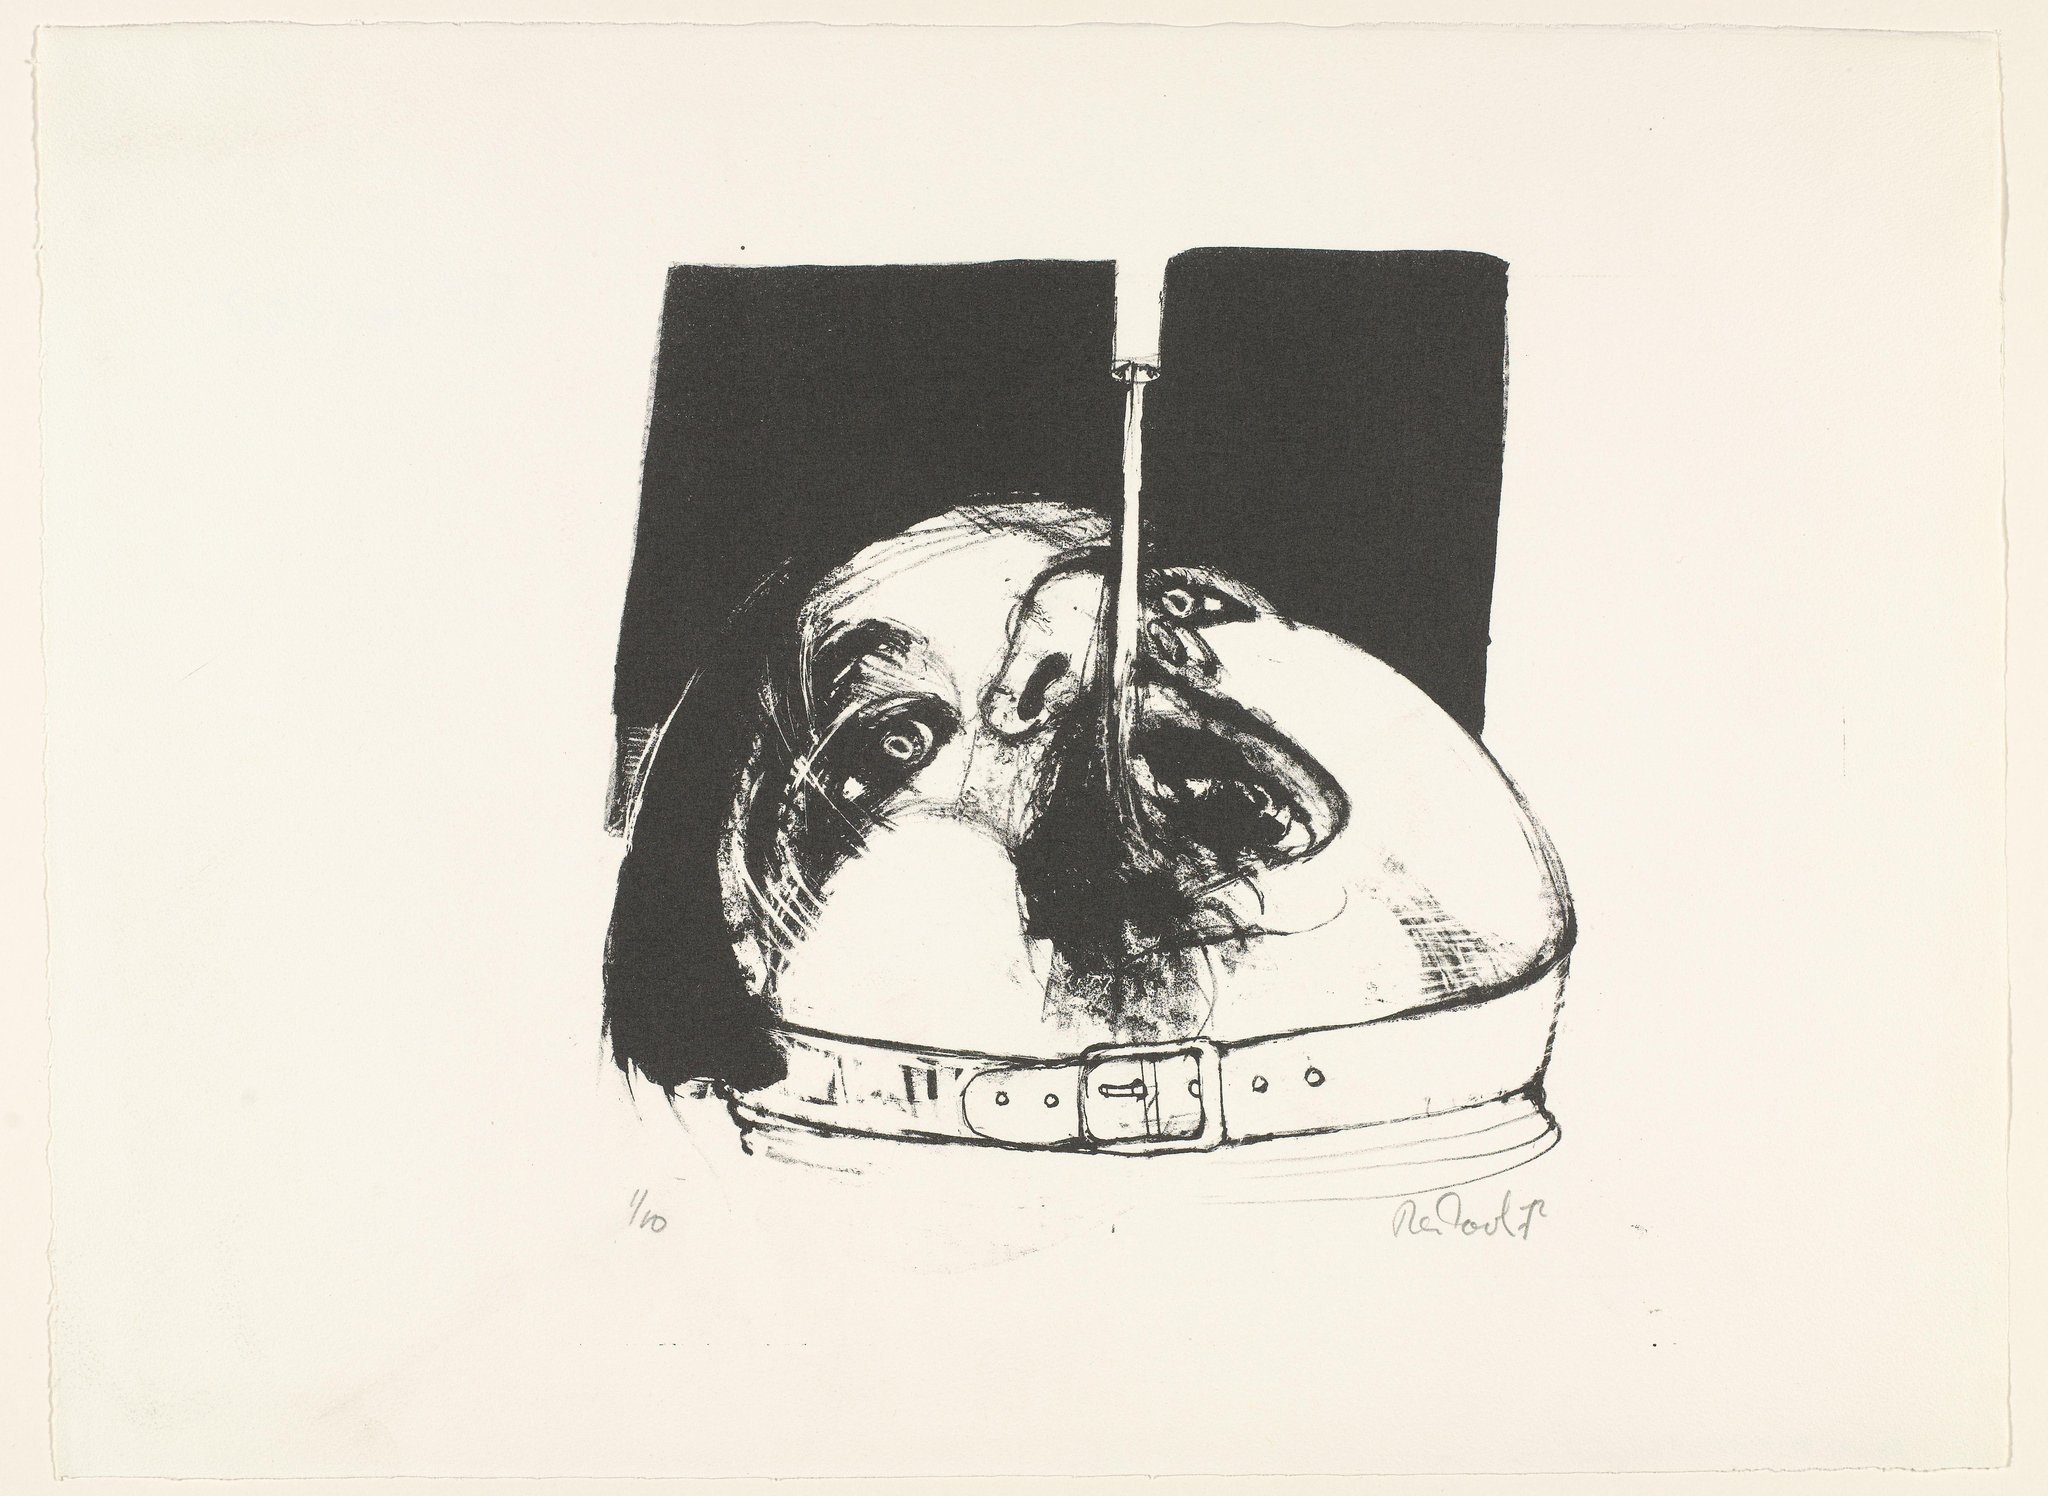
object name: print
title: Drinkende figuur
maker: rein dool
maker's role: draughtsman, painter, print maker, sculptor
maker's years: 1933-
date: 1972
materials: paper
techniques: lithograph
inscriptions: signature and date: ‘Rein Dool 72’, edition: ‘1/10’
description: Achteroverleunende figuur met riem om de nek, drinkend van een waterstraal.